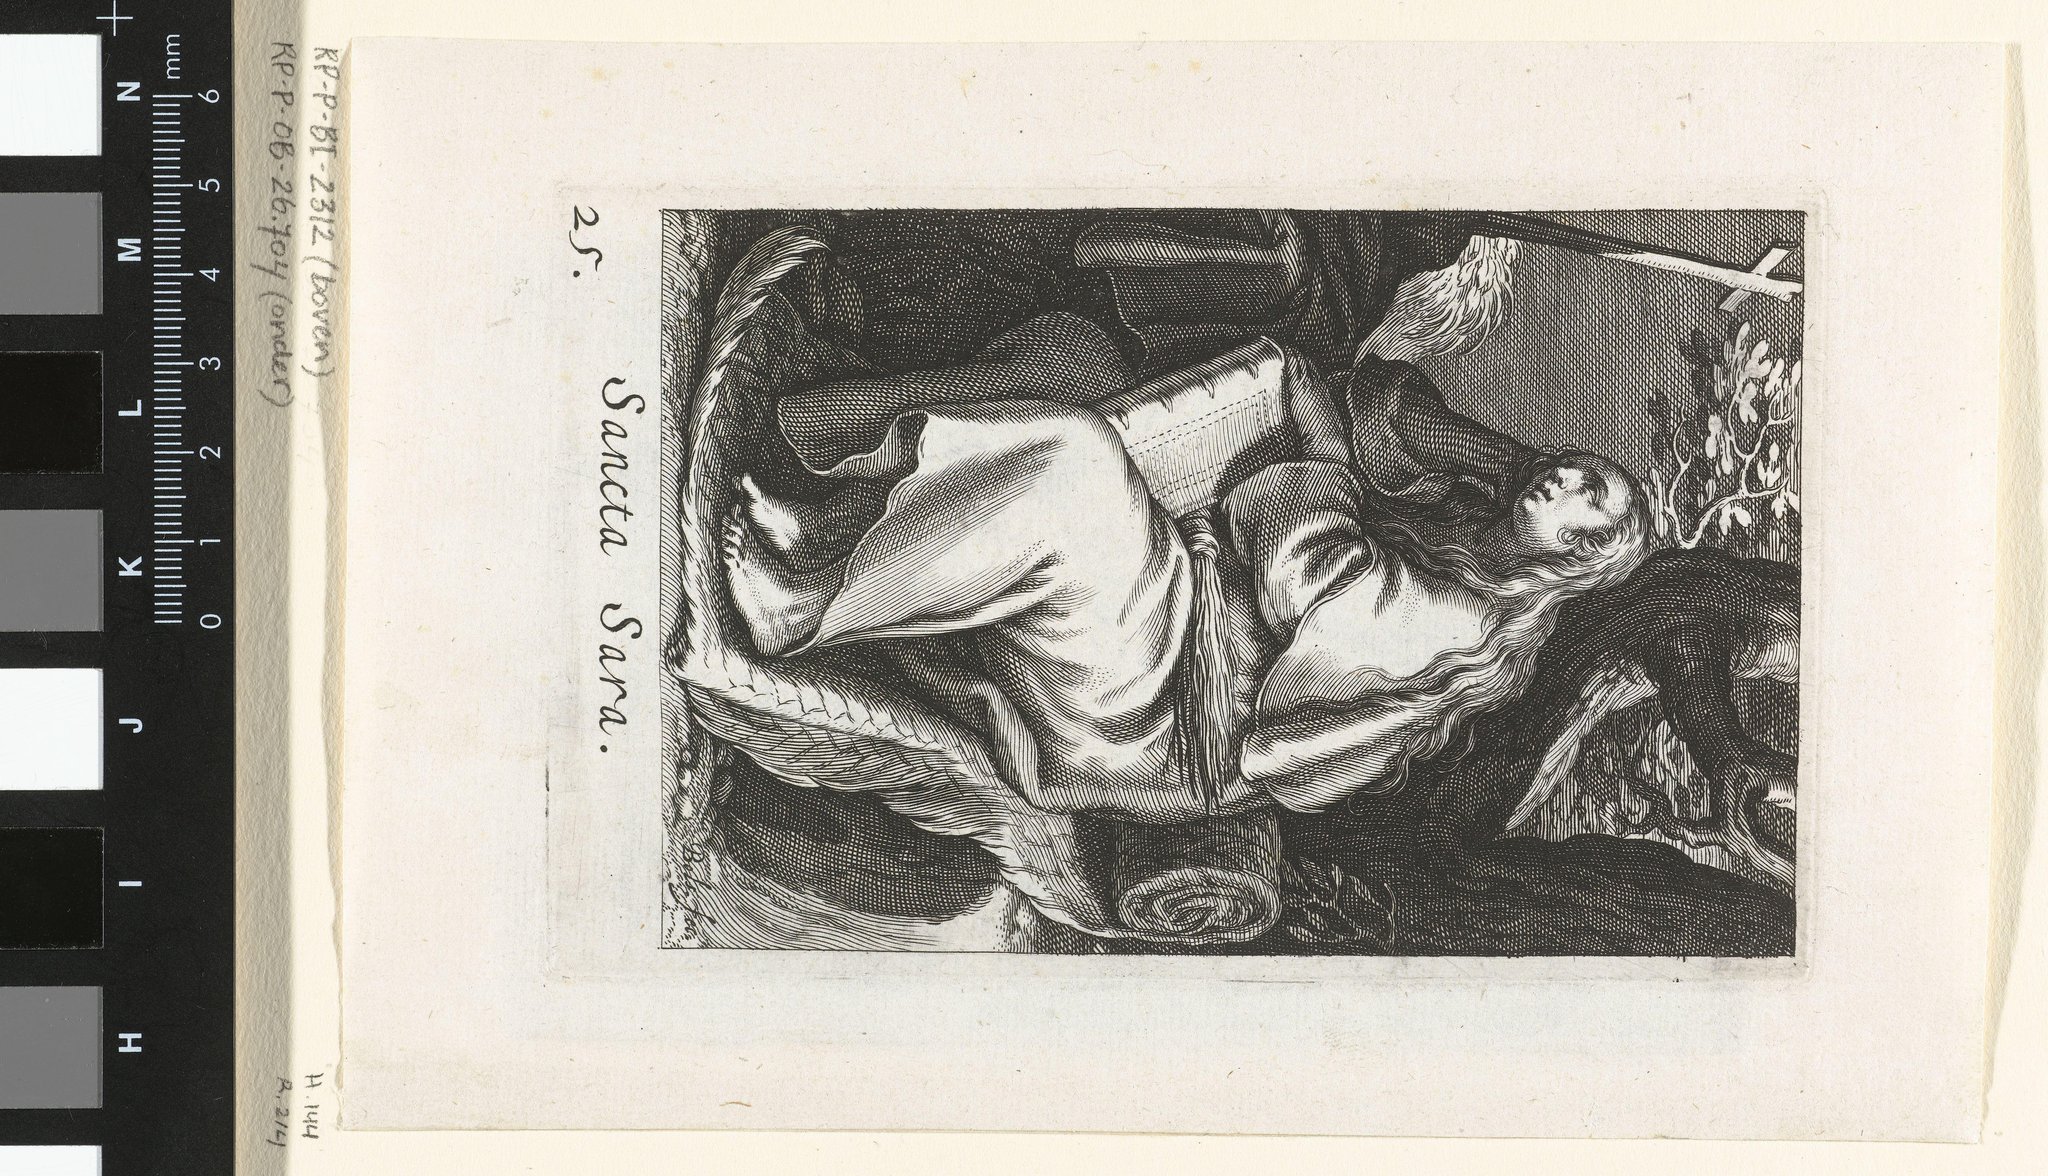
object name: book illustration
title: Sacra Eremus Ascetriarum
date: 1590-1612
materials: paper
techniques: engraving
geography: antwerp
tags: anchorite, hermit, female saints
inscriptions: collector's mark: Lugt 2228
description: Prent uit: Sacra Eremus Ascetriarum, uitgever Boëtius Adamsz. Bolswert, 1612 of Hendrik Aertssen, Antwerpen 1619. Prent uit de serie van vijfentwintig kluizenaressen in deze uitgaven. In 1612 verscheen een ongebonden editie maar op basis van de gewijzigde opschriften en samenstelling van de serie kluizenaars wordt aangenomen dat de prenten van de uitgave 1619 ook in 1612 of iets daarvoor gedrukt werden. De serie kluizenaressen bleef vrijwel ongewijzigd in de ongebonden uitgave van 1612, dit compliceert de datering van de losse bladen in de collectie van het RMA, zie Roethlisberger 1993, p. 171-175.